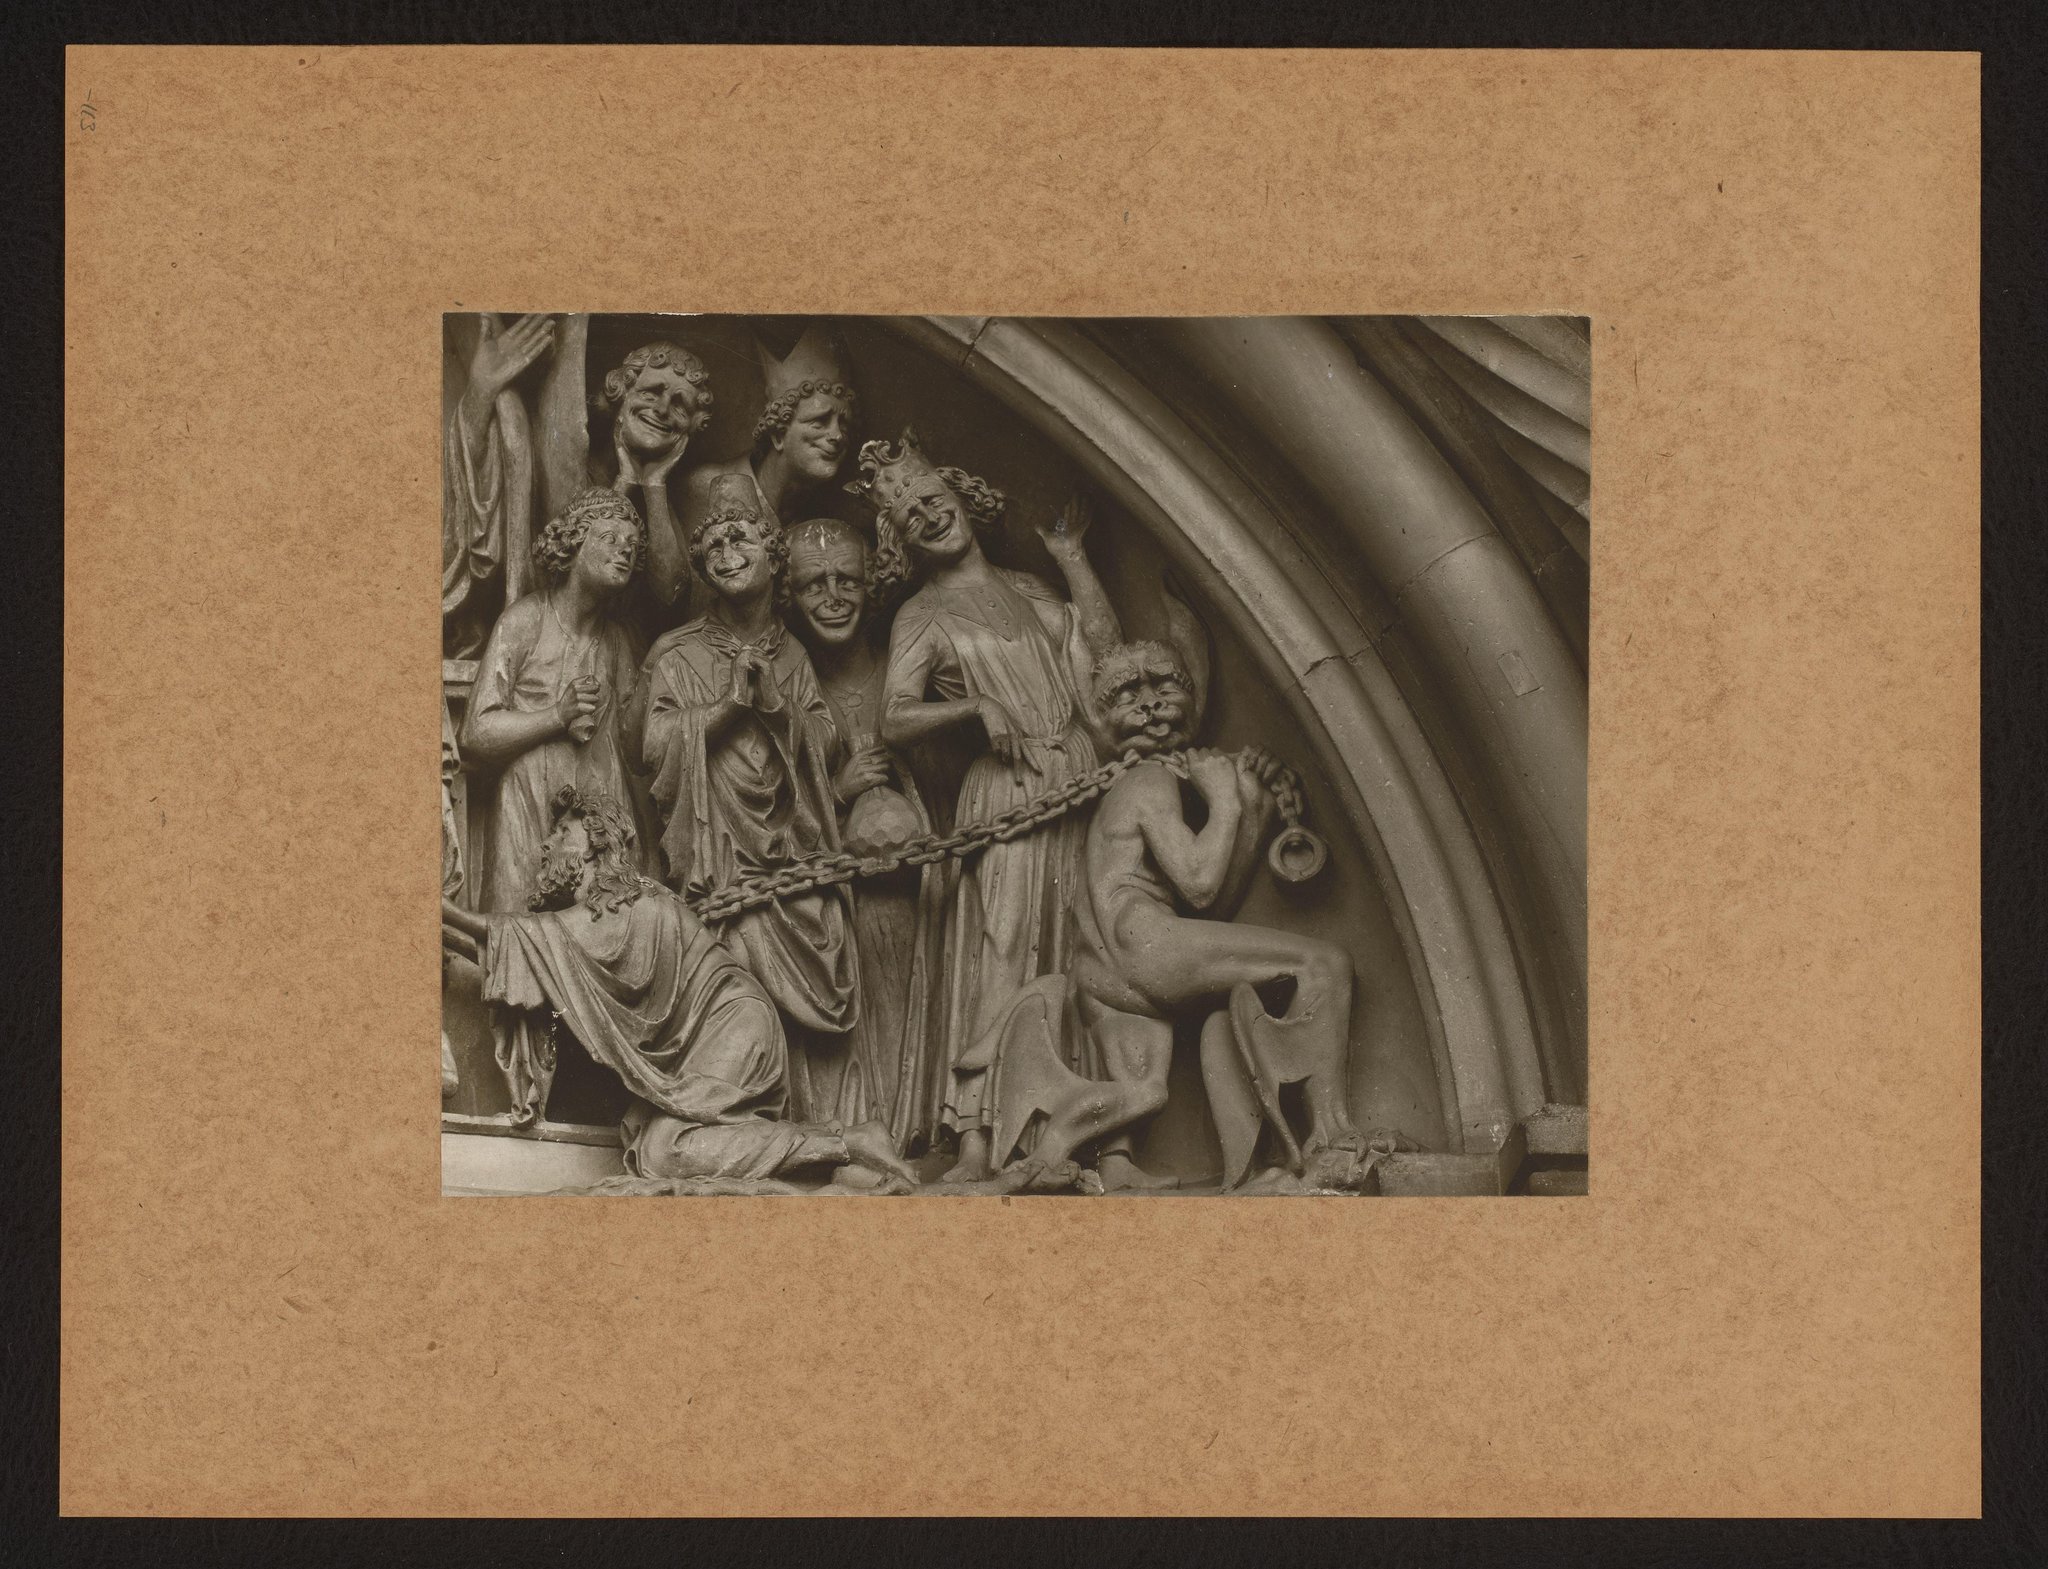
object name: photograph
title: Detail van het timpaan van het Fürstenportal in de dom van Bamberg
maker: Anonymous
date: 1900-1920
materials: paper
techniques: gelatin silver print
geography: bamberg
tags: church (exterior)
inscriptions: number: ‘116.’